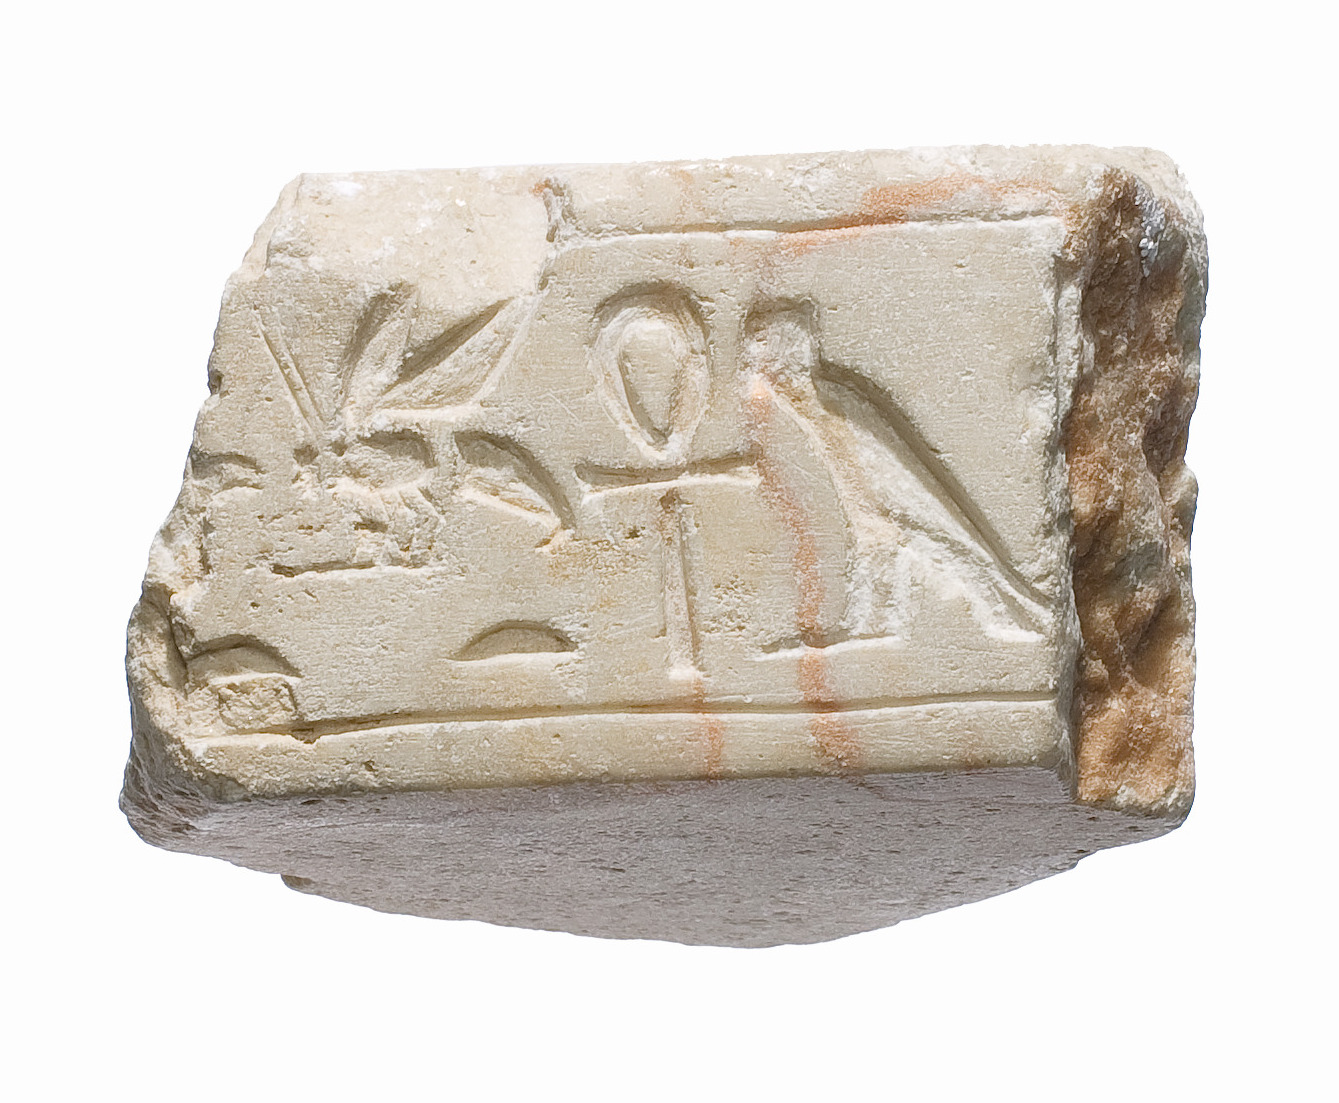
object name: offering table, inscribed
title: Offering table with Akhenaten titles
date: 1353-1336 BCE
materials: limestone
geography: egypt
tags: hieroglyphs